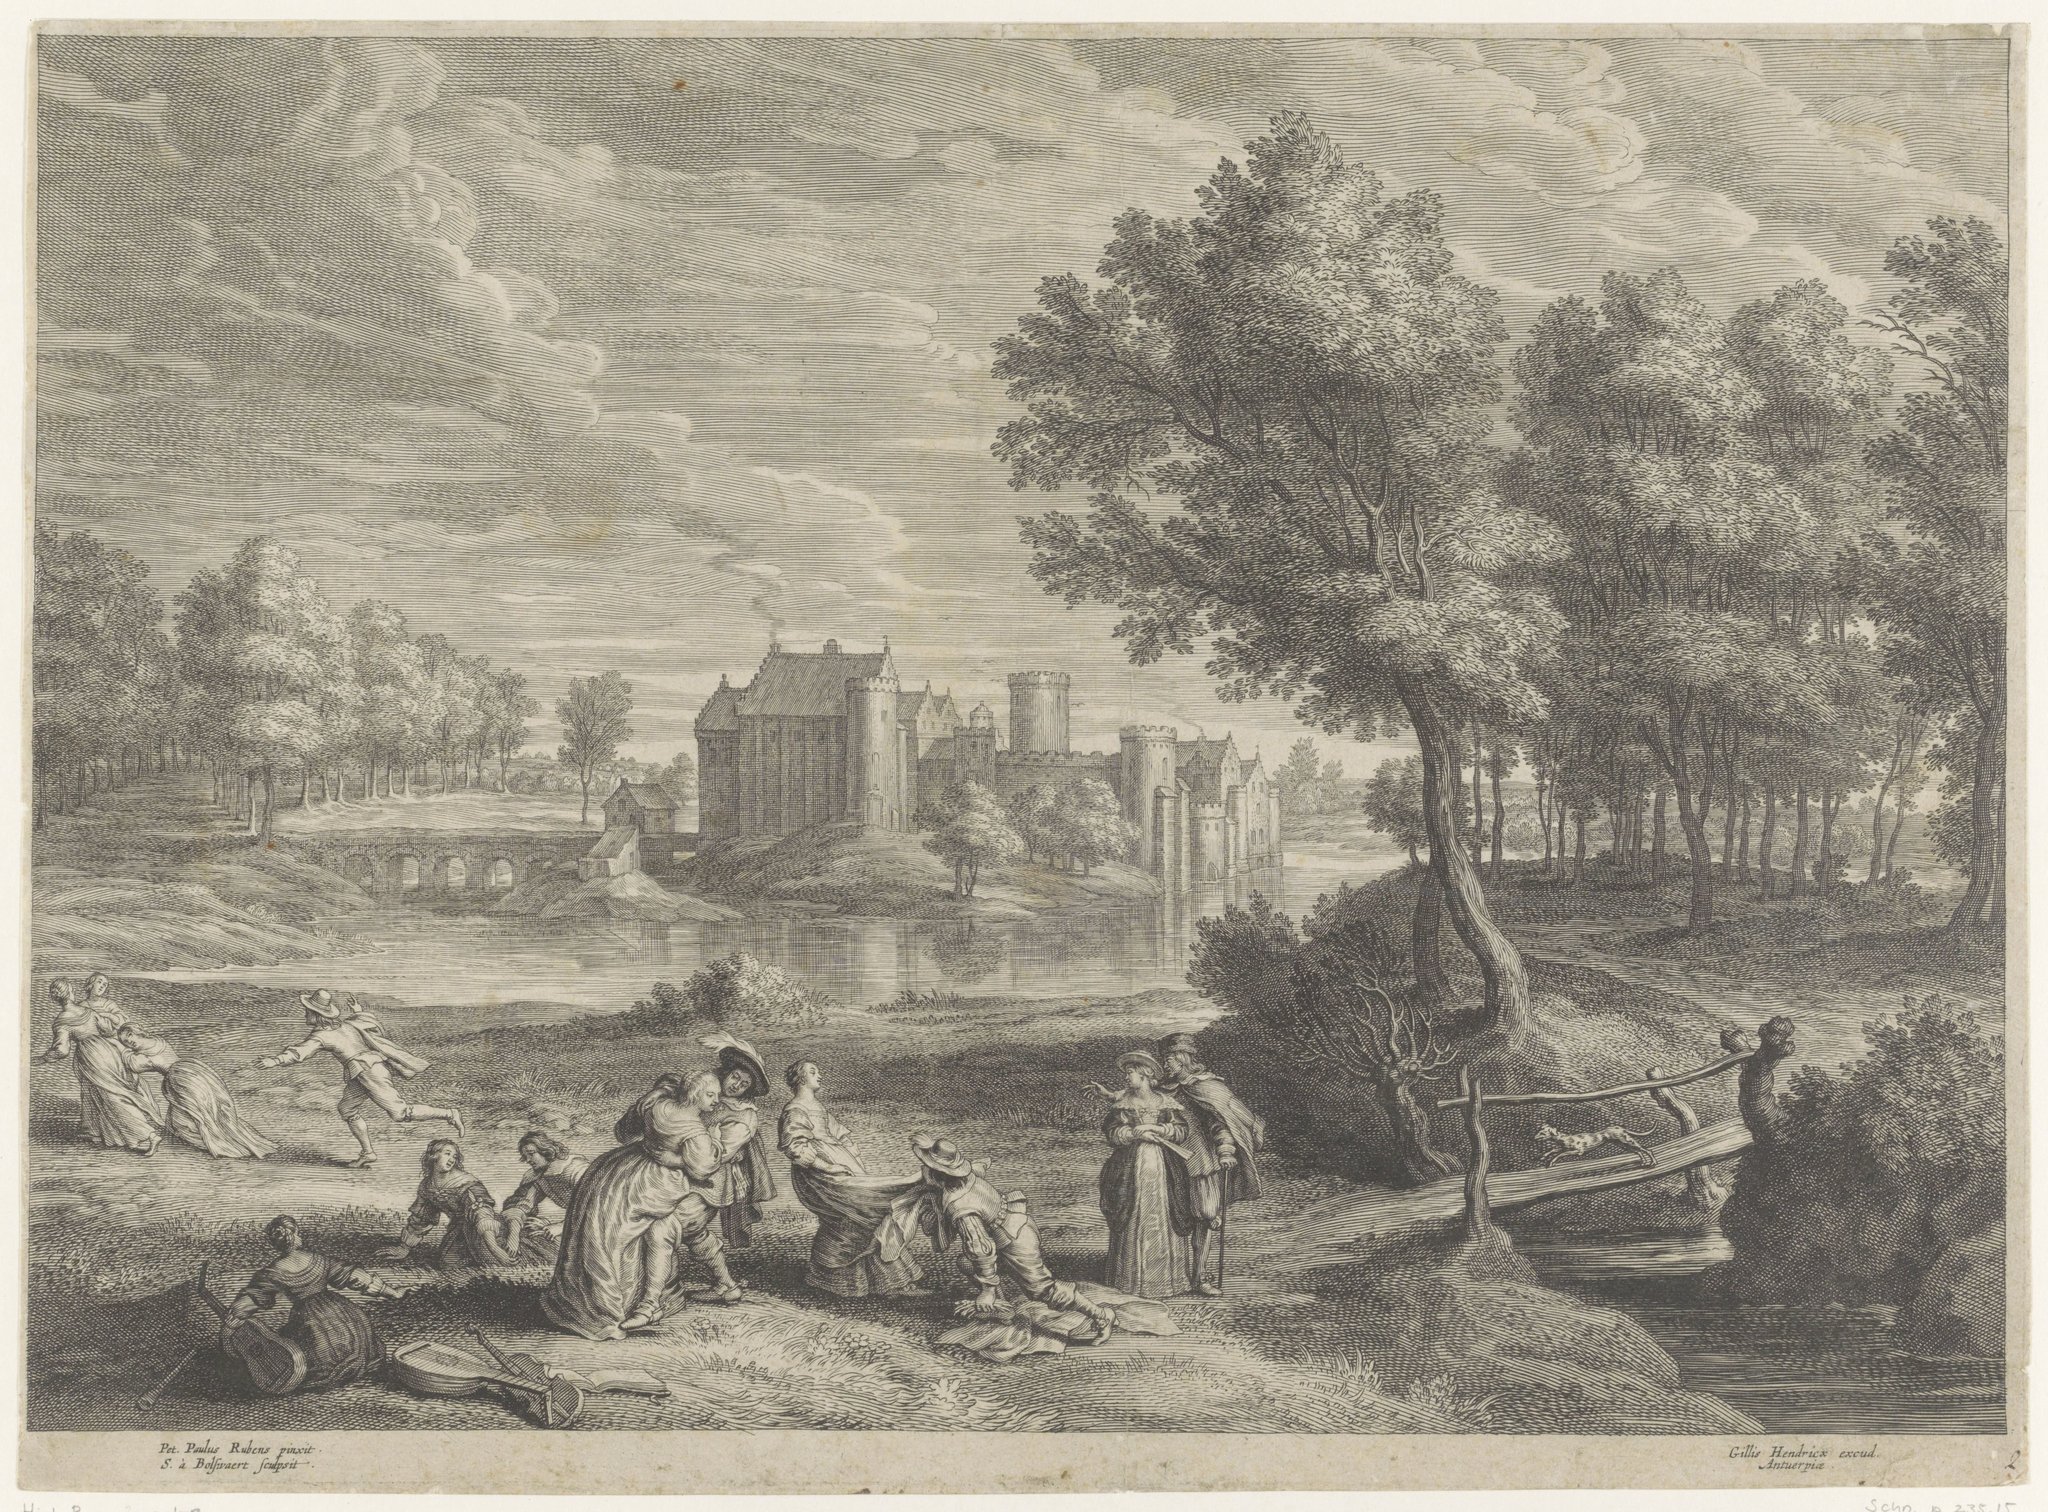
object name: print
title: Landschap met kasteel en gezelschap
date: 1596-1659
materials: paper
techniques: engraving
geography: antwerp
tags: visiting; receiving guests; elegant company, landscape with tower or castle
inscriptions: inscription: ‘B 29 39-58’, collector's mark: Lugt 10, collector's mark: Lugt 11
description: Prent naar schilderij van Peter Paul Rubens. Hollstein beschrijft een serie kleine landschappen onder de nrs. 305 t/m 325 maar deze prenten zijn niet als reeks vervaardigd.